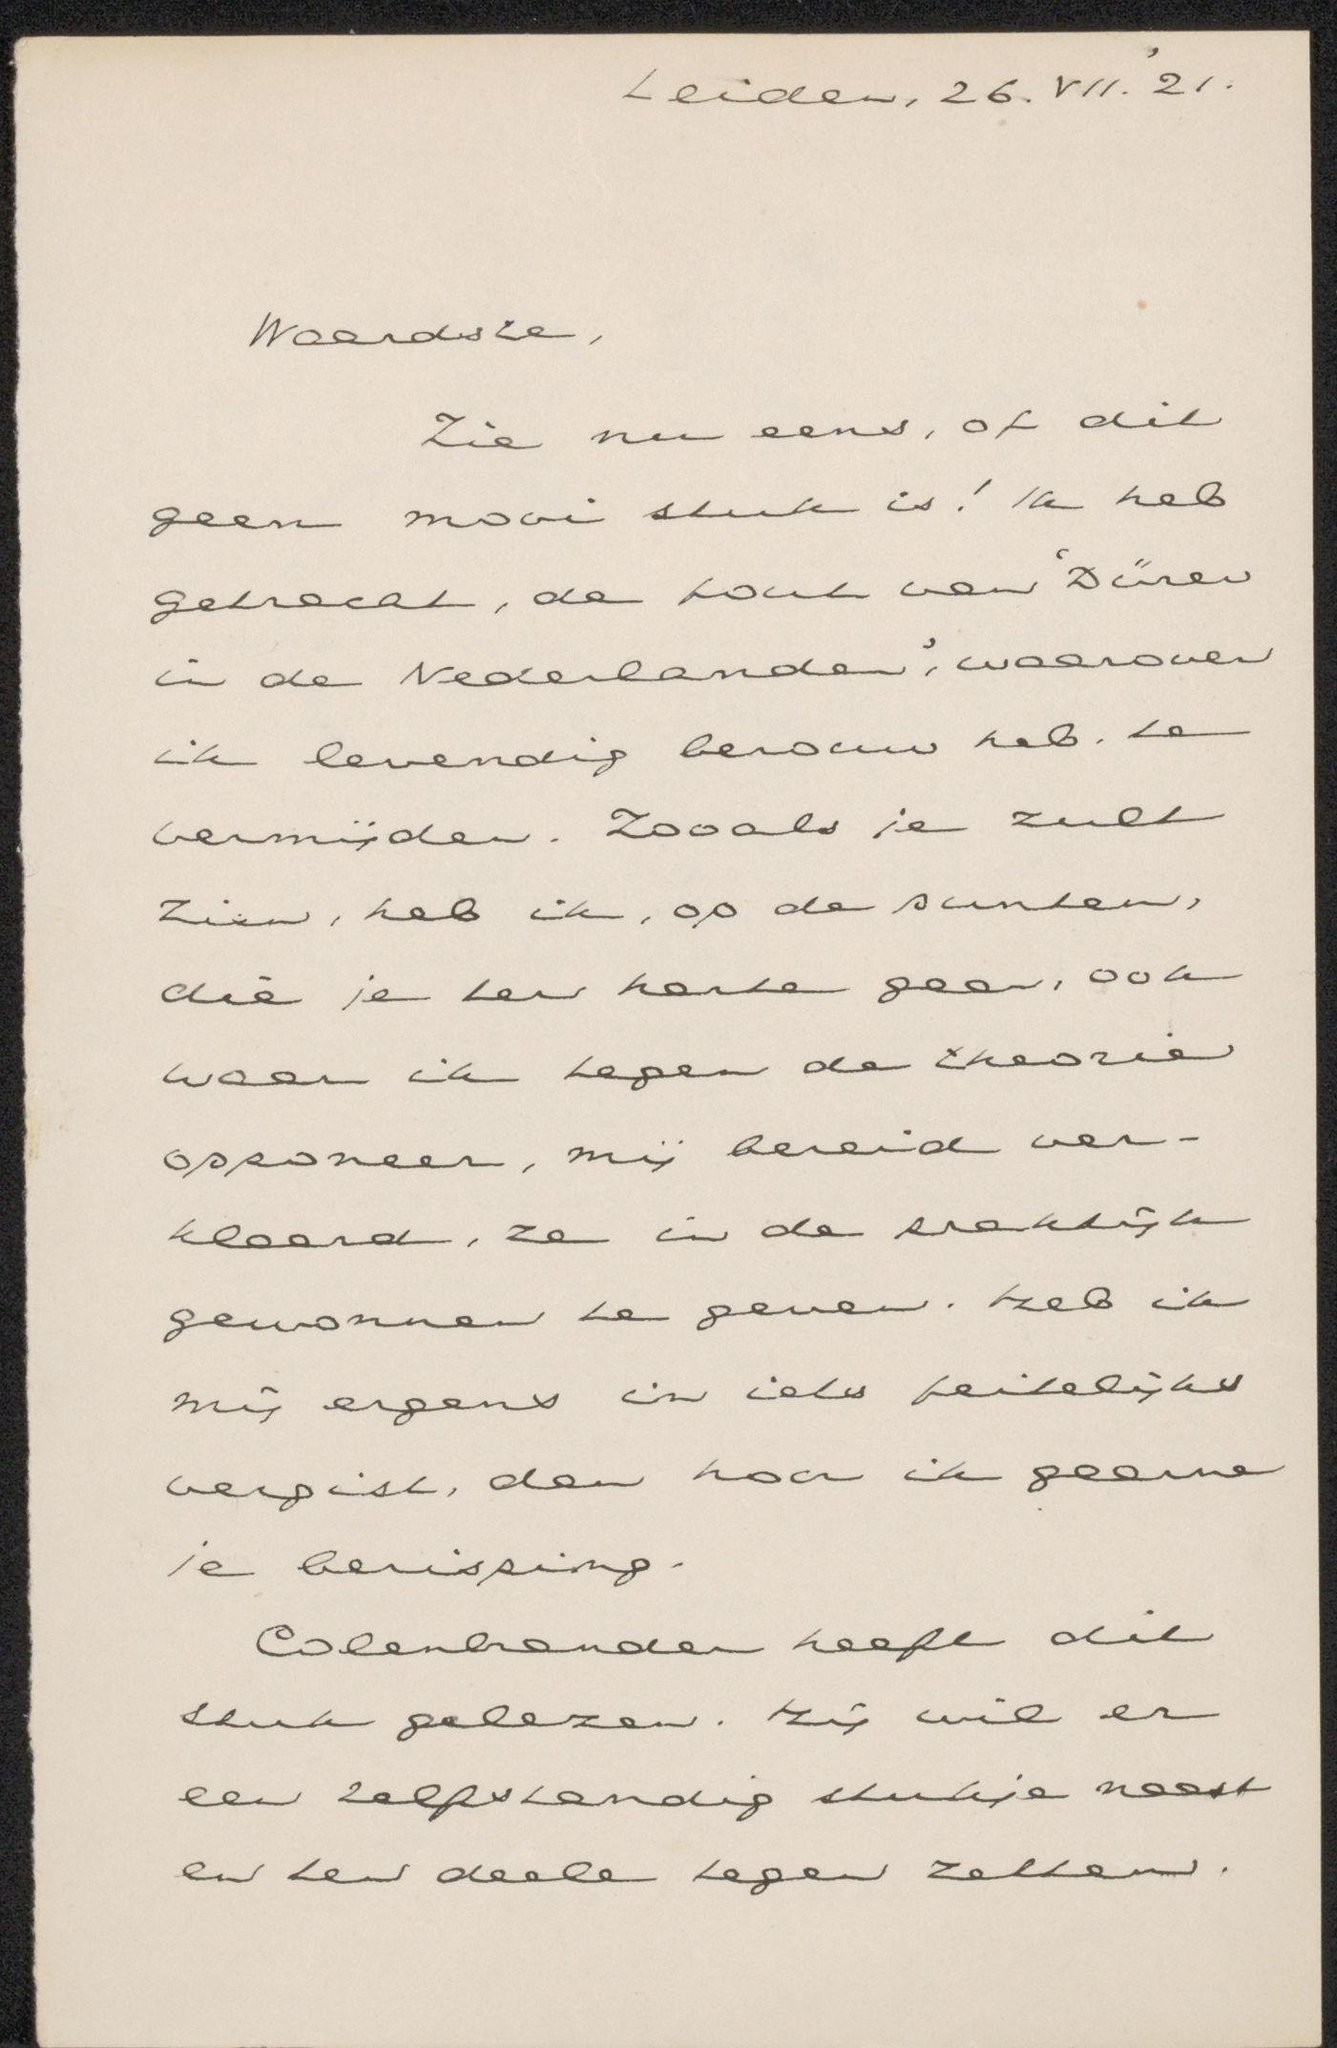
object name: letter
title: Brief aan Jan Veth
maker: johan huizinga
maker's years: 1872-1945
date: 1921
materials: ink, paper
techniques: pen, writing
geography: leiden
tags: jan veth, painter, print maker, draughtsman, albrecht dürer, herman theodoor colenbrander, family life, diseases, art collecting, printed matter, amsterdam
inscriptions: collector's mark: ‘RPK’, watermark